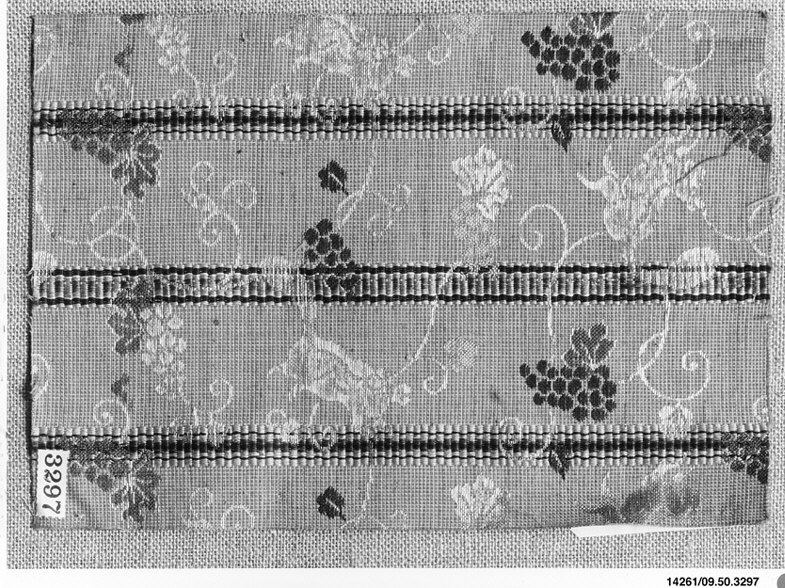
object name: piece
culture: japanese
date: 1801-1900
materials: silk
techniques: brocade